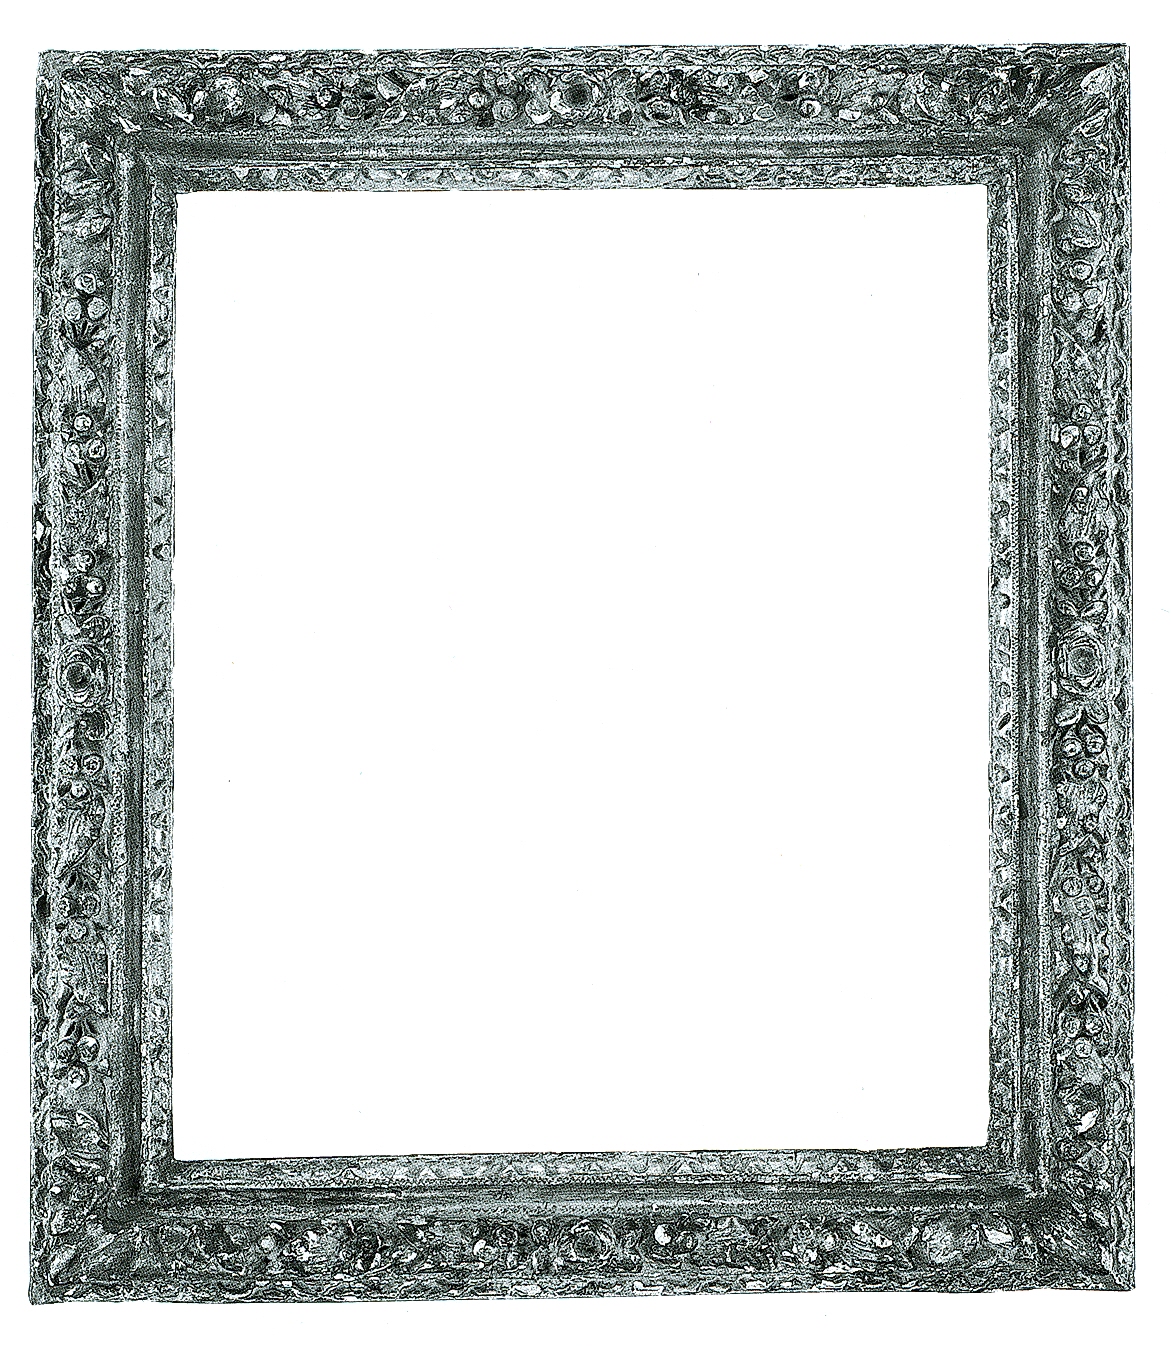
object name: frame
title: Astragal frame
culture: french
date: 1640-1650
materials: wood